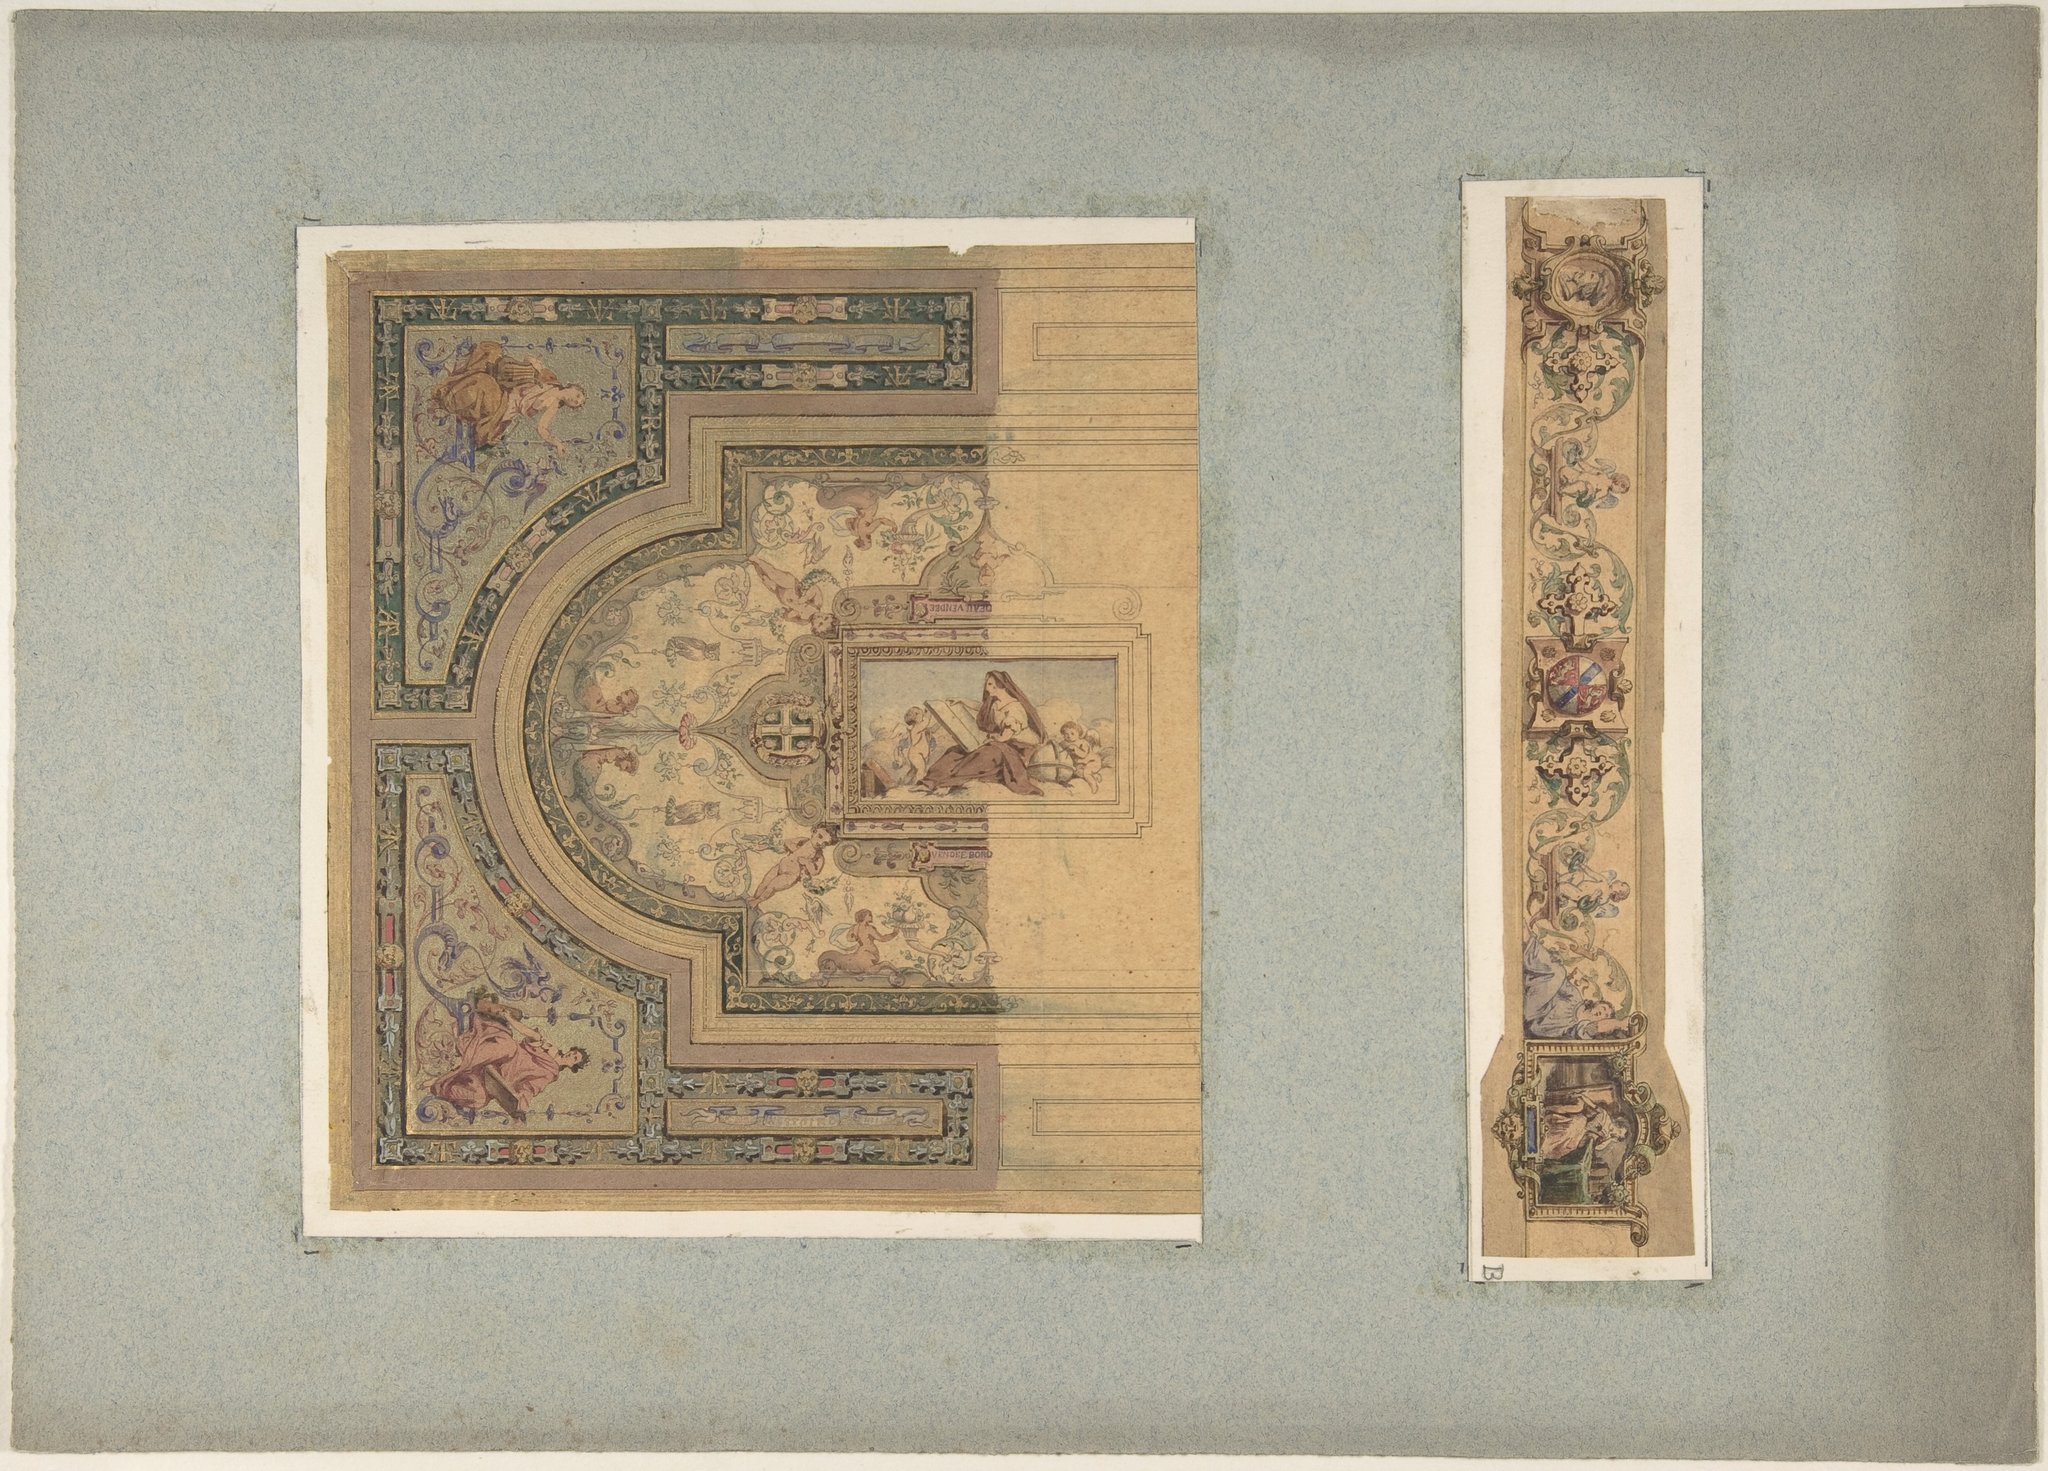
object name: drawing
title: Two Designs for Ceiling with Putti and Allegorical Figures of the Arts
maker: jules-edmond-charles lachaise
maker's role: artist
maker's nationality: french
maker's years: 1897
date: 1851-1900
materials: gilt, graphite, ink, watercolor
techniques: pen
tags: women